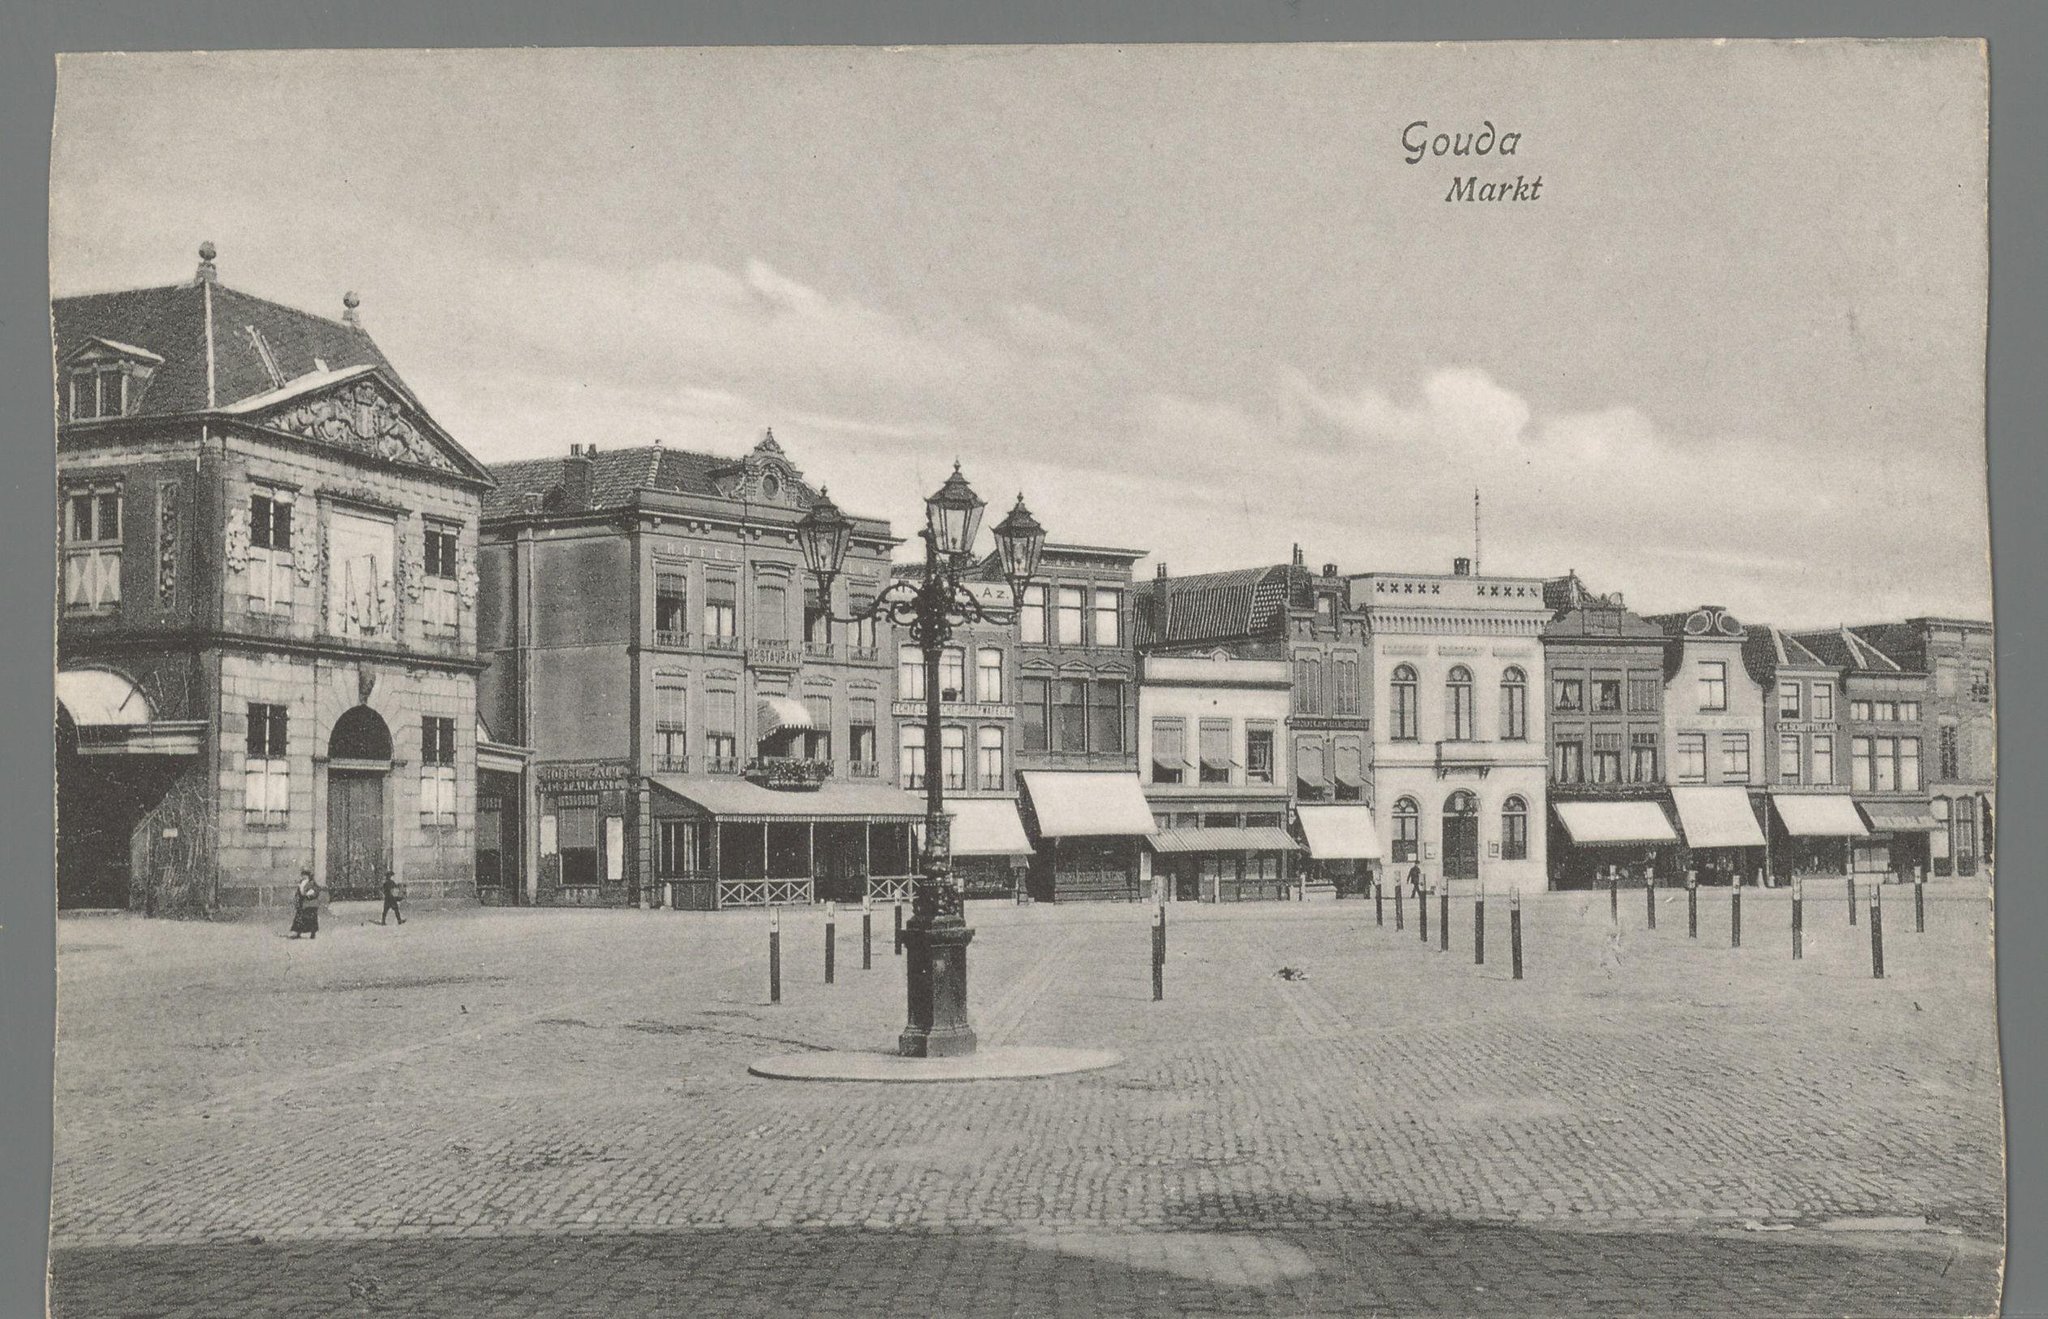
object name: photomechanical print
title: Gouda. Markt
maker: Anonymous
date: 1908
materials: cardboard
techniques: photograph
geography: gouda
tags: square, place, circus, etc., street lighting, gouda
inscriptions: date